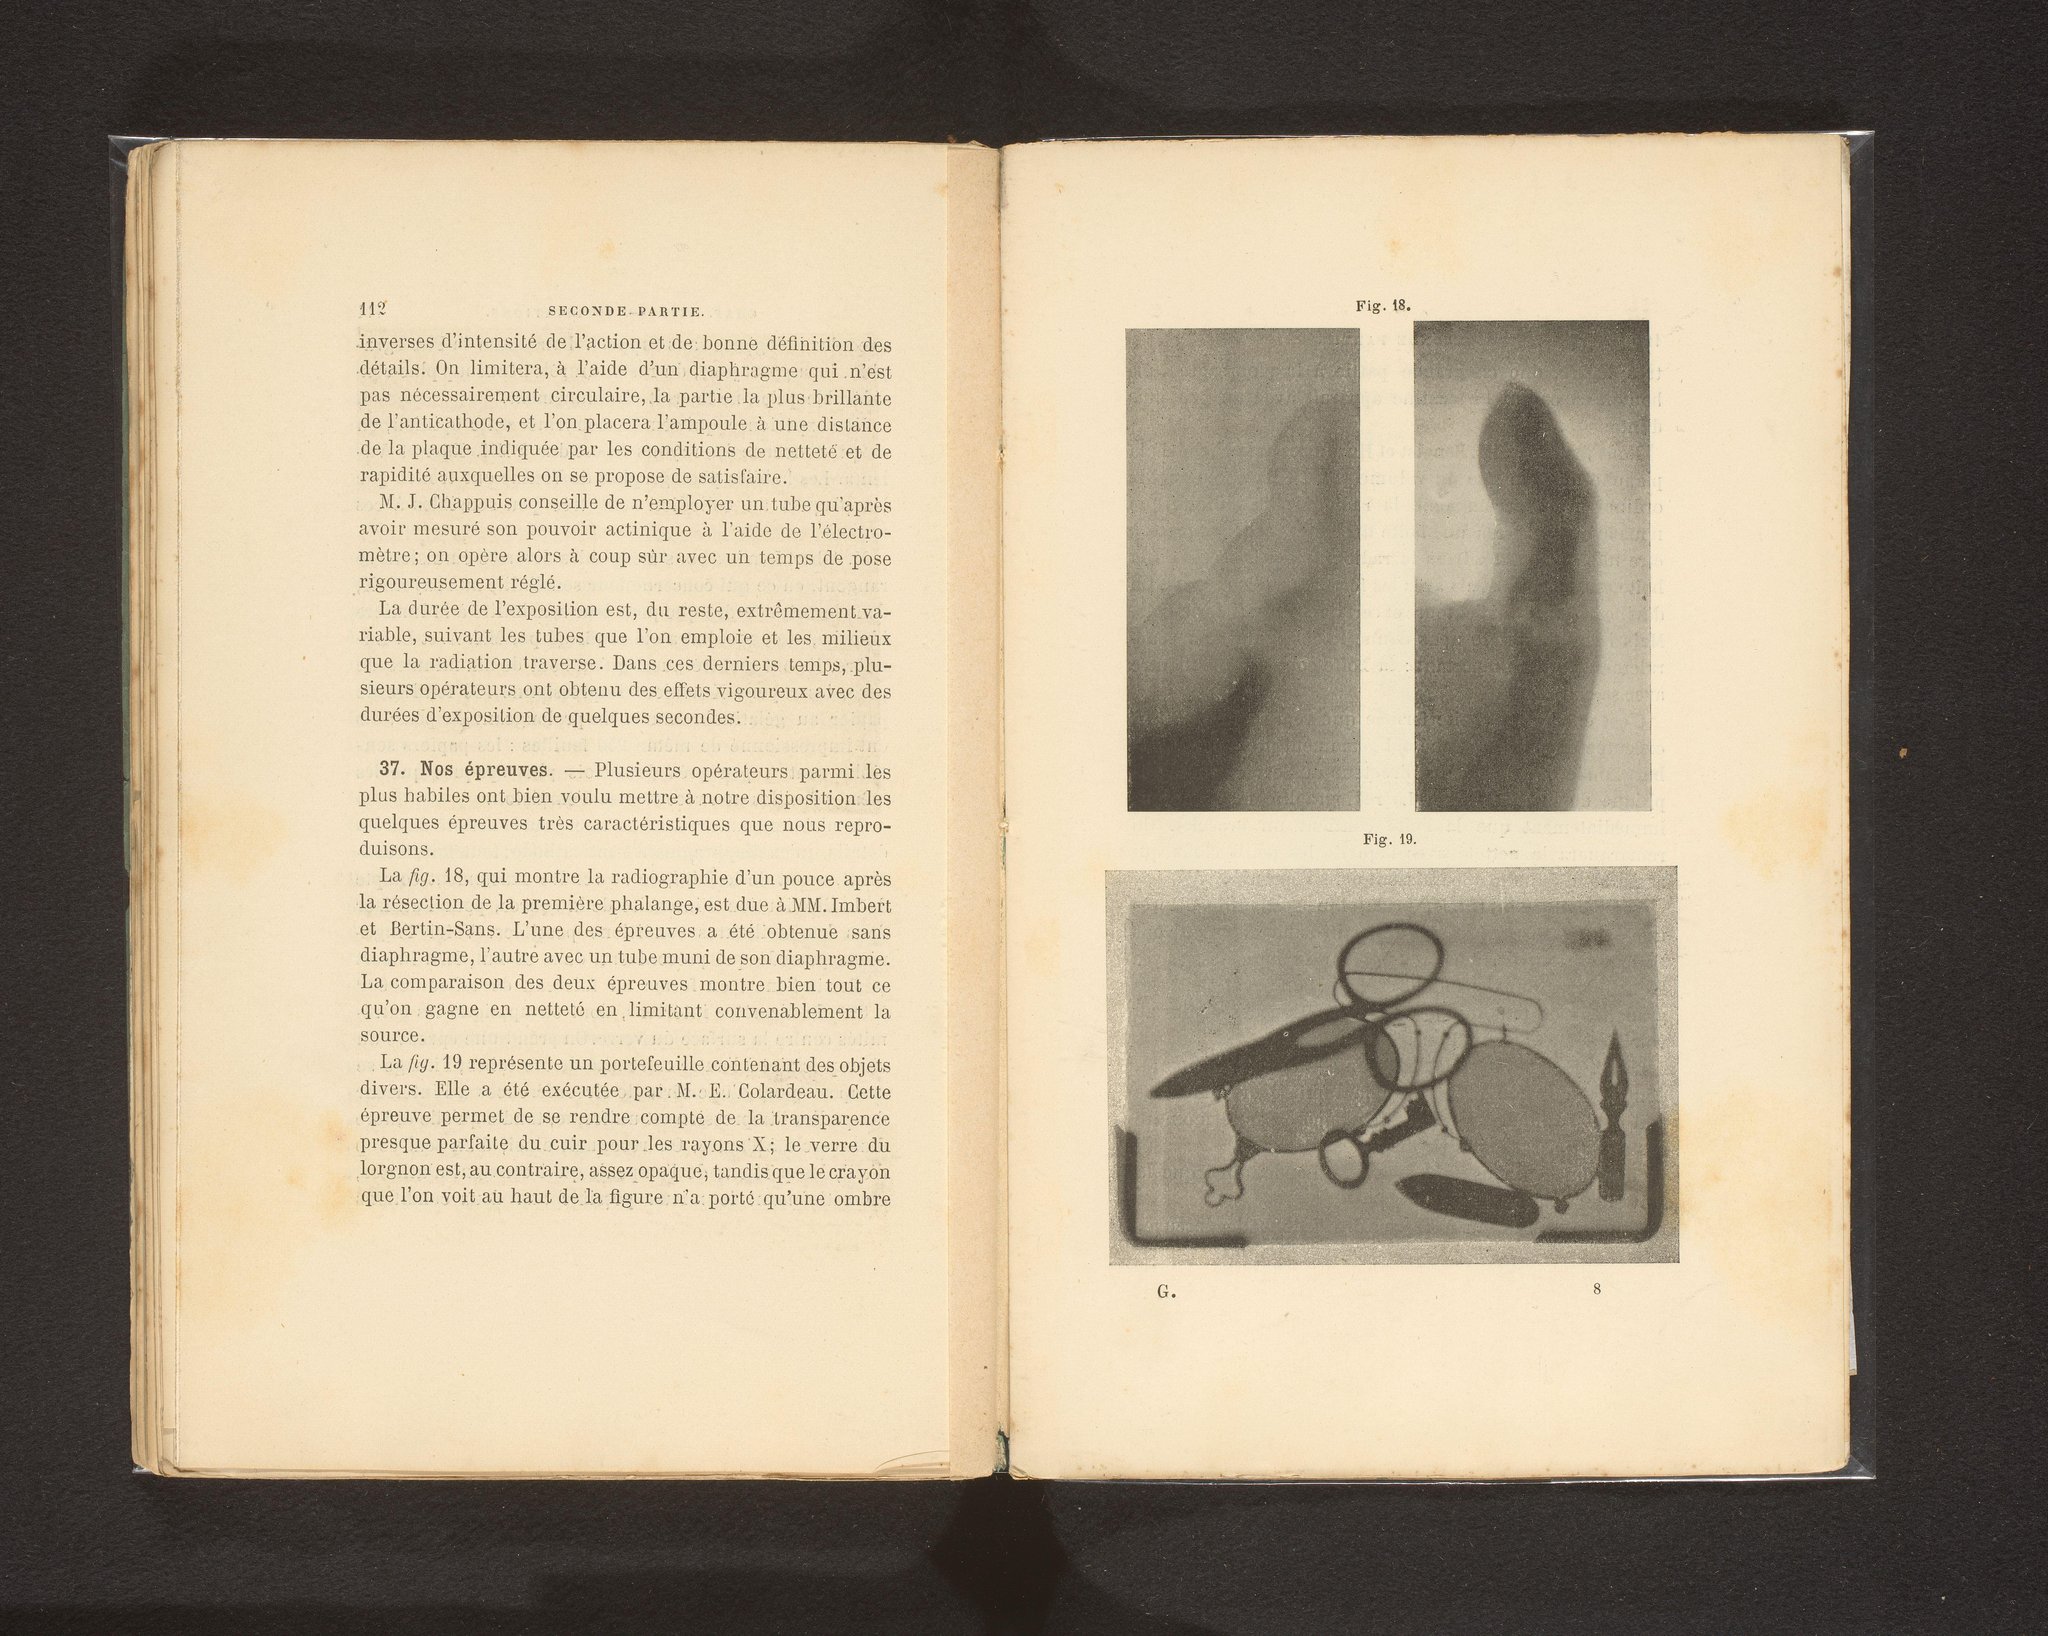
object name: page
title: Röntgenopnamen van een duim en een portefeuille met onder andere een schaar, een sleutel en een kroontjespen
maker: Anonymous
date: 1886-1896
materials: paper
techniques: autotype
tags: x-ray examination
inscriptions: number: ‘Fig. 18. Fig. 19. G. 8’